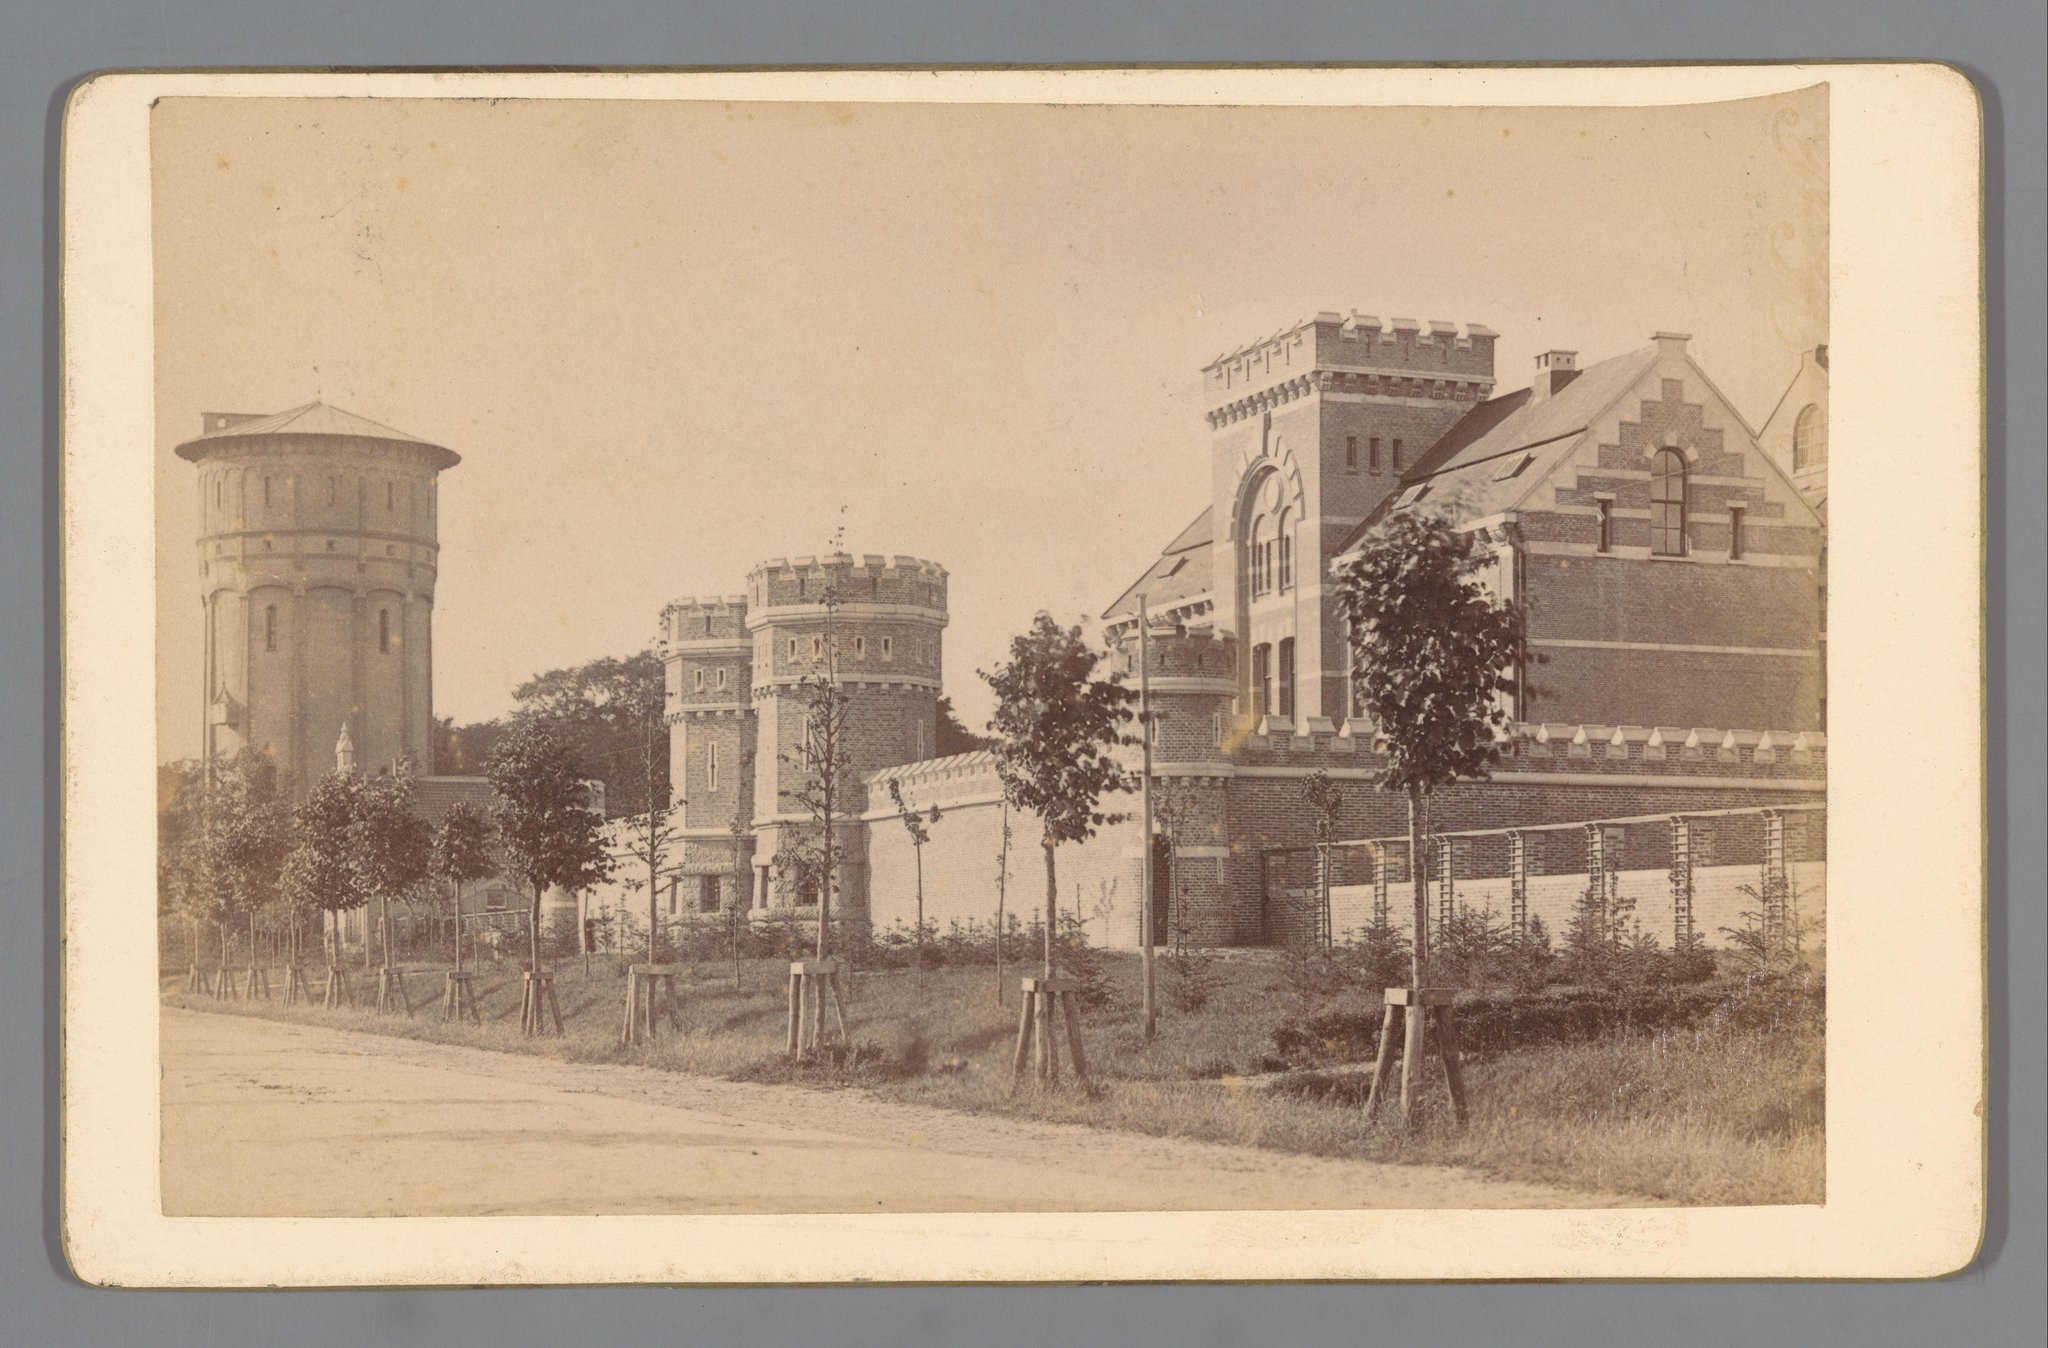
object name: photograph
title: Exterieur van de Cellulaire Strafgevangenis te Groningen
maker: johannes gerardus kramer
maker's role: fotograaf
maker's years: 1845-1903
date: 1880-1900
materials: cardboard, photographic support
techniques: albumen print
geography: groningen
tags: prison, jail, façade (of house or building)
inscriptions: inscription: ‘Groningen?’, name: ‘J. G. Kramer Groningen’